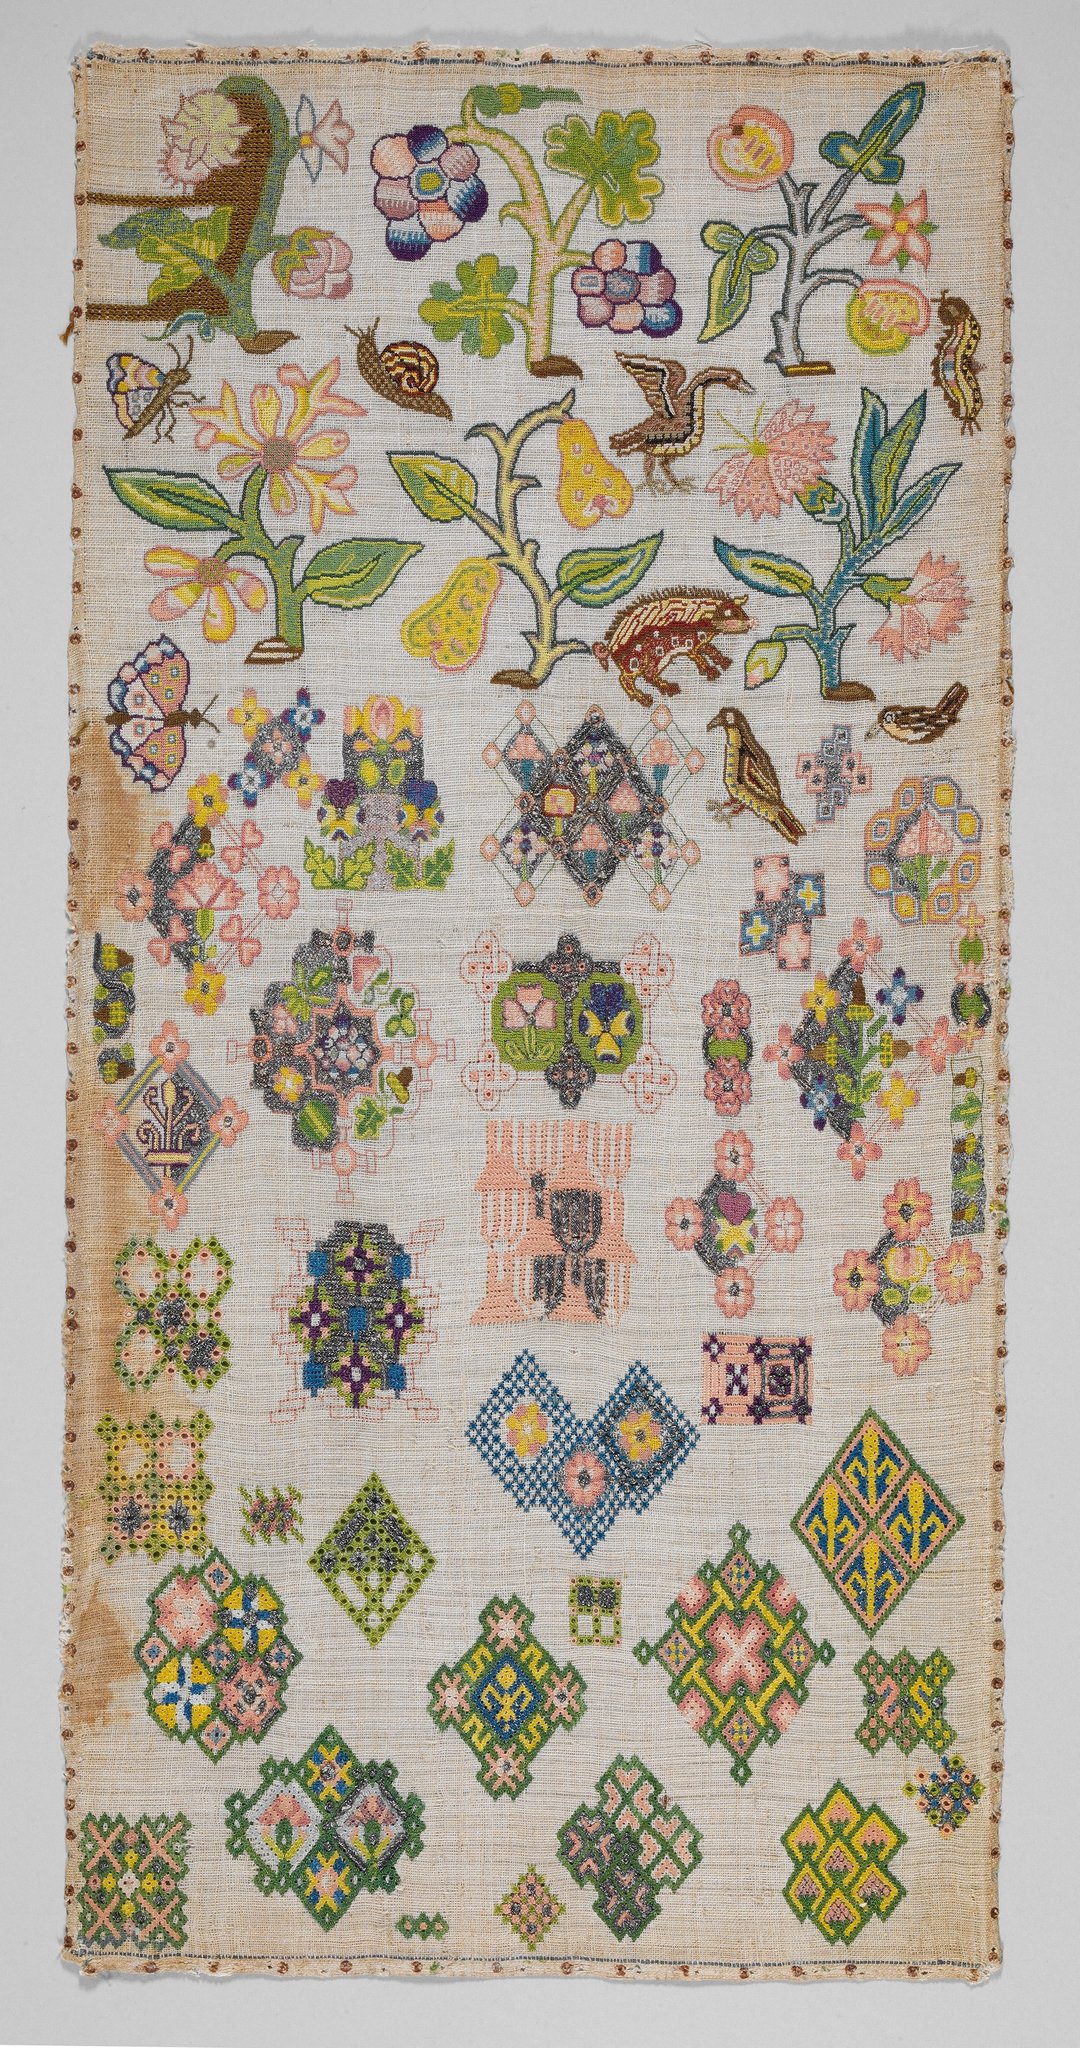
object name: sampler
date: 1634-1666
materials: canvas, metal thread, silk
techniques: laid work, stitching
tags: birds,boars,butterflies,snails,flowers